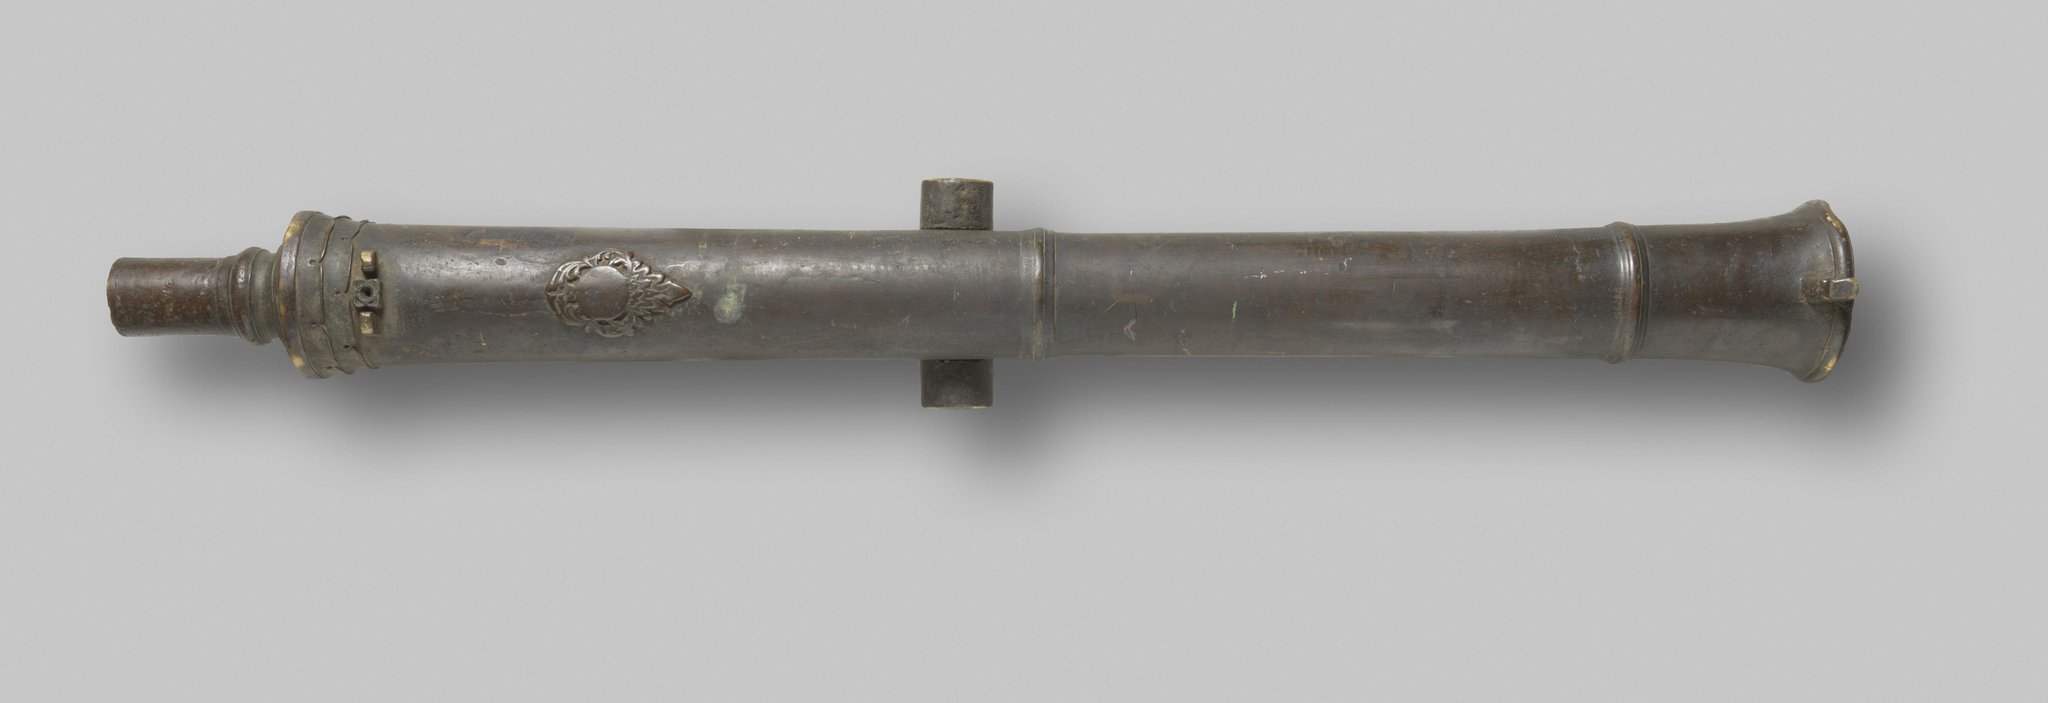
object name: lilla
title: Lantaka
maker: Anonymous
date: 1750-1850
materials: bronze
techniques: casting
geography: indonesian archipelago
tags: tanjung pulisan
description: Bronzen voorlader op mik. De ronde loop heeft een trompetvormige monding en het achtergedeelte is dikker; holle staart voor een houten richtstok. Aan weerszijden van het zundgat een knop voor een zundgatdeksel. Vóór het zundgat een lege ovale cartouche. De hoogste sierraadband en kulas zijn met een eenvoudig motief versierd. Vlak achter de monding een richtknop. De ogen van de mik zijn geheel om de de tappen heen gesmeed, zodat het stuk niet uit de mik getild kan worden.